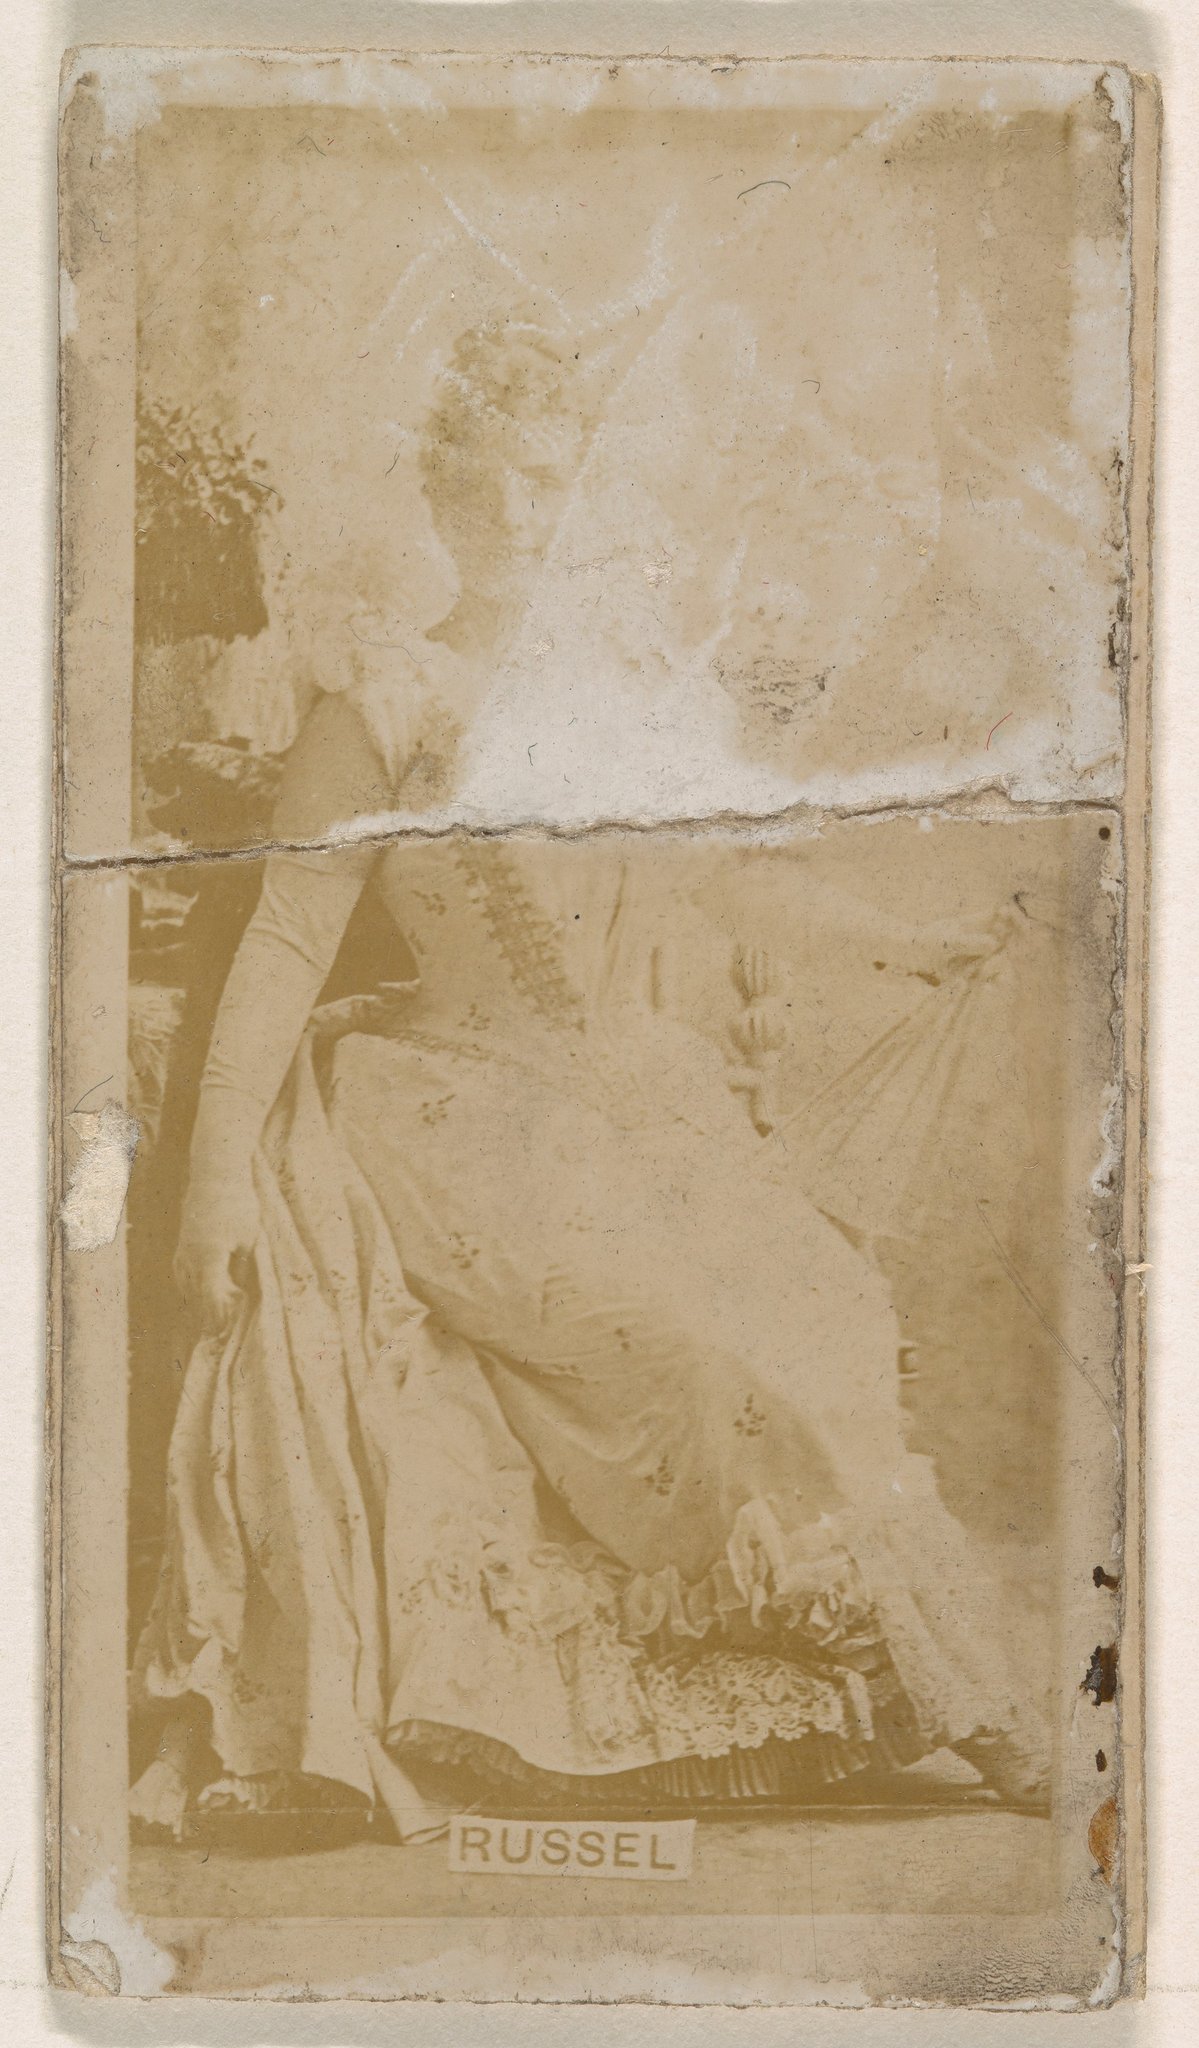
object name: photograph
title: Russell, from the Actresses series (N245) issued by Kinney Brothers to promote Sweet Caporal Cigarettes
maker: kinney brothers tobacco company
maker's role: publisher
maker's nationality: american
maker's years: 1869-2011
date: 1890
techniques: albumen silver print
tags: portraits,women,actresses